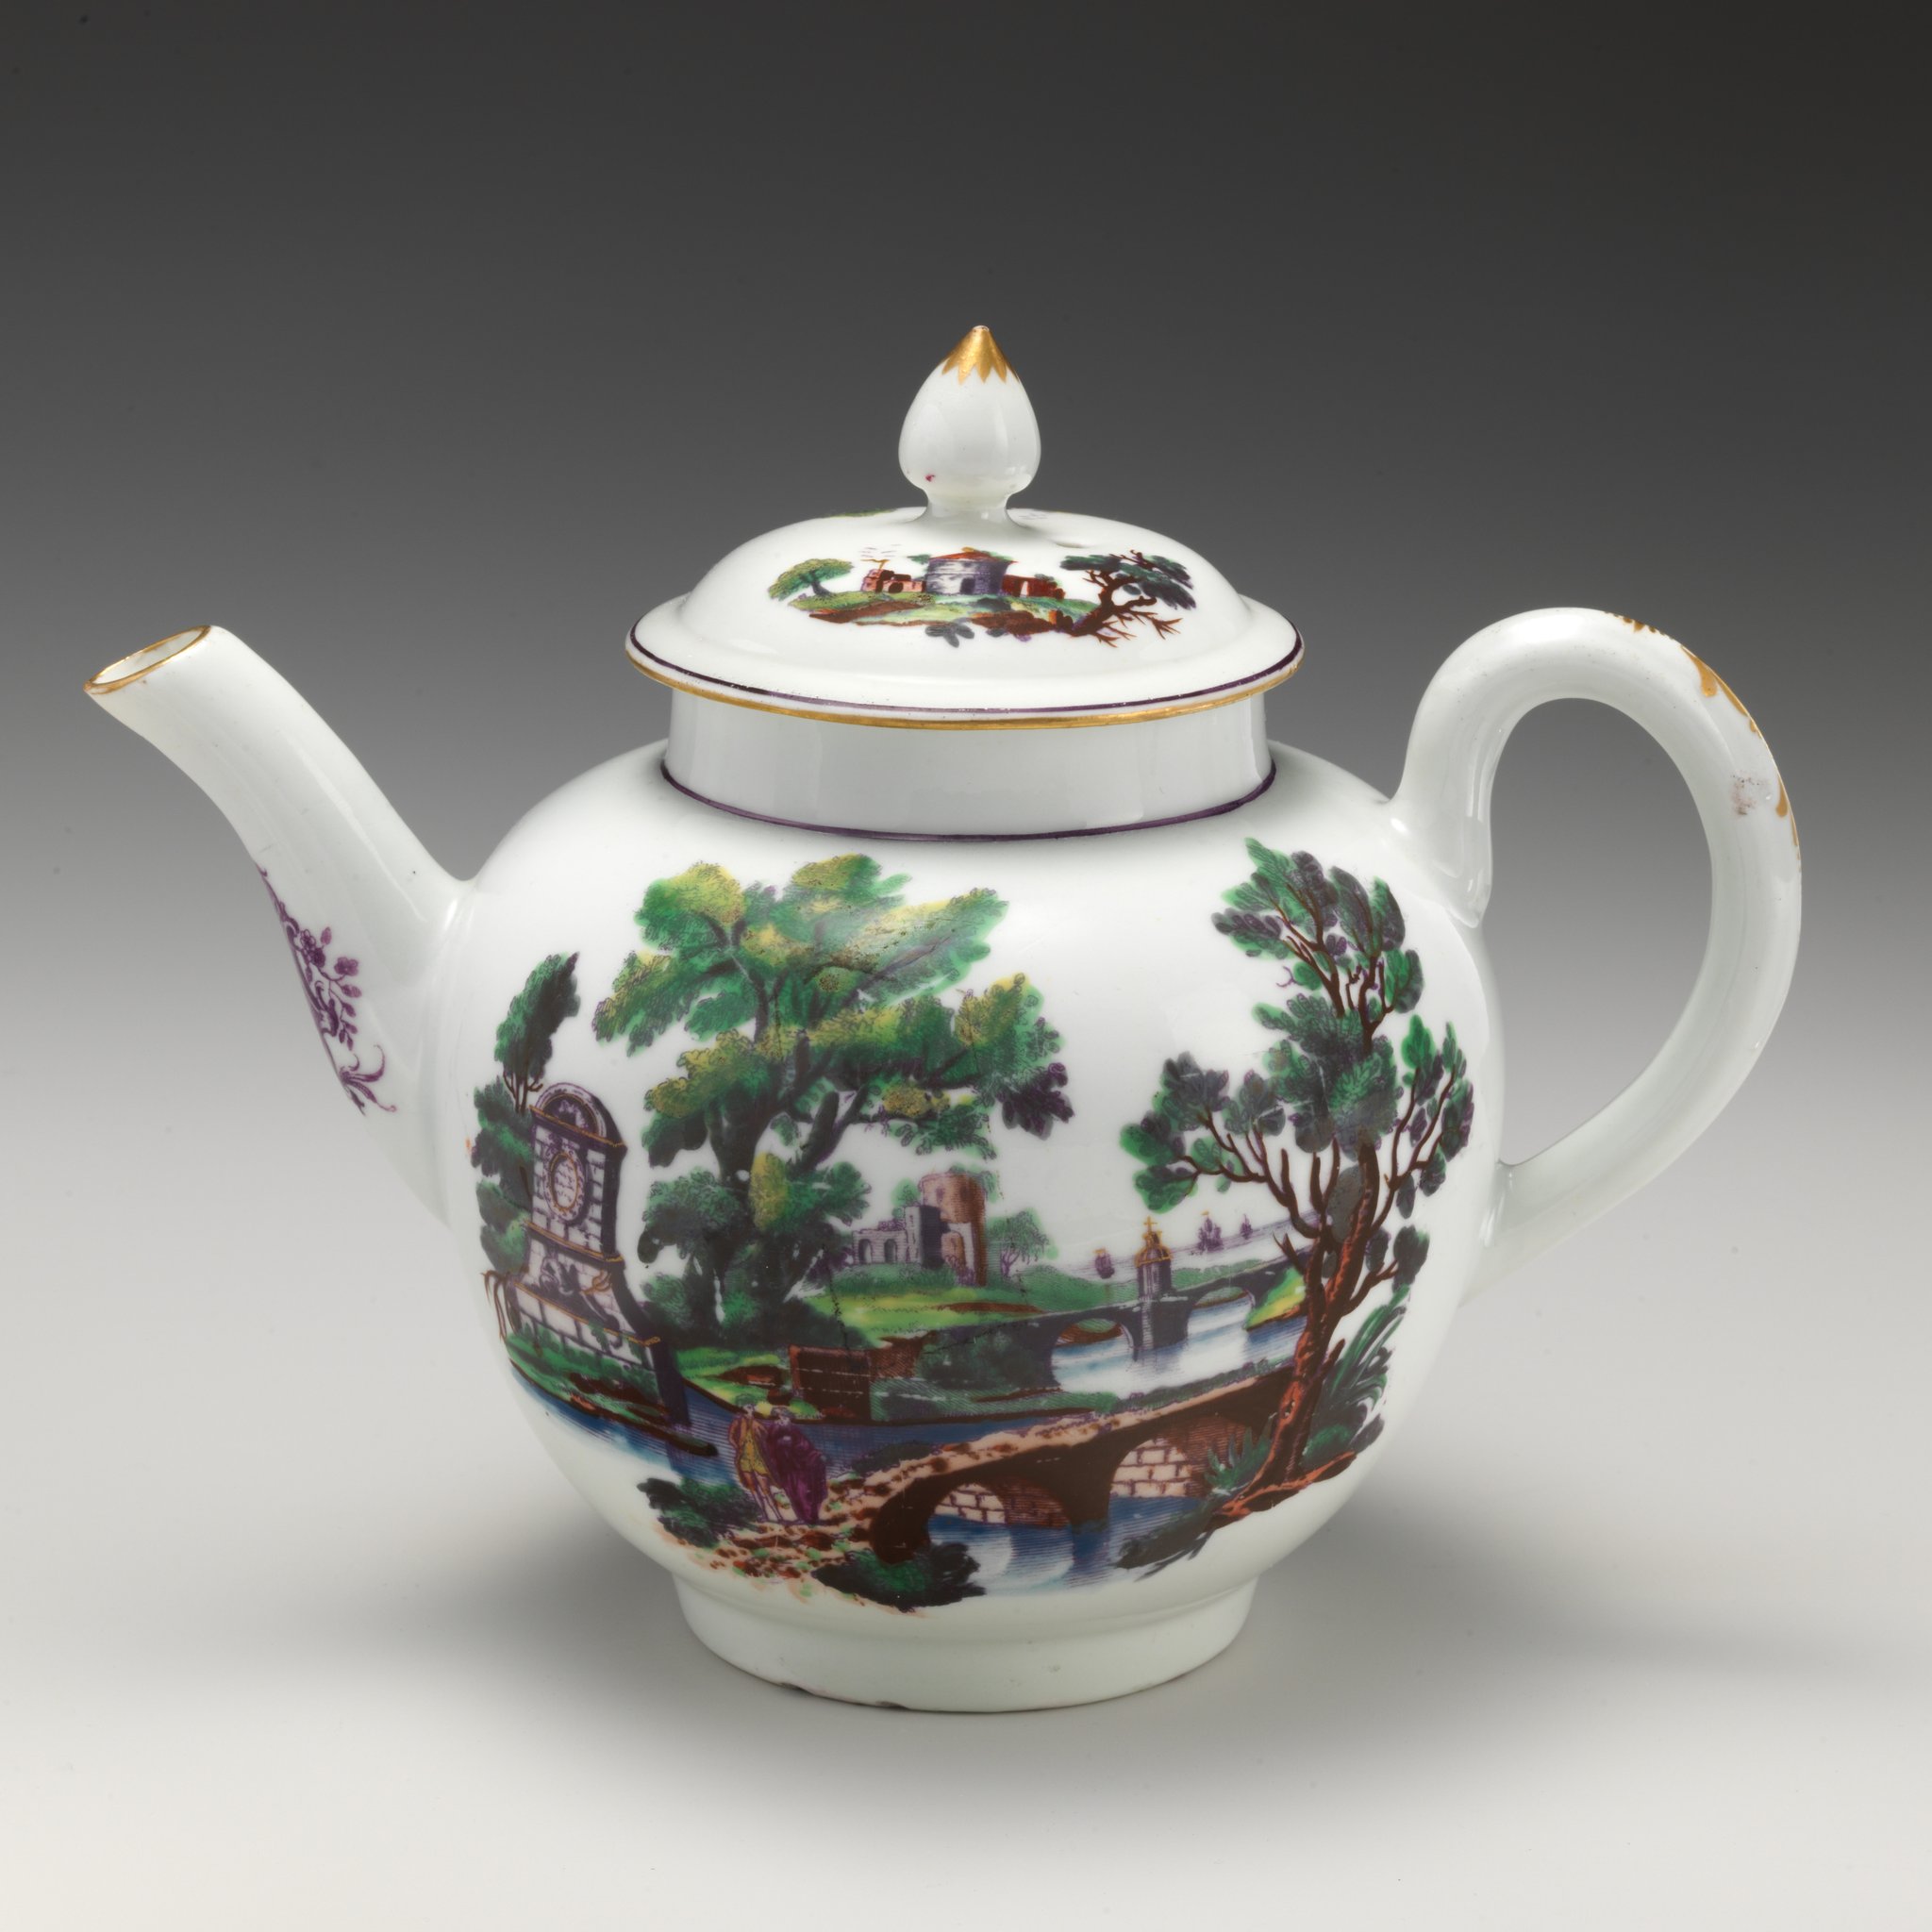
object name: teapot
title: Teapot with landscape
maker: worcester factory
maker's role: factory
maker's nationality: british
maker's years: 1751-2008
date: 1770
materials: soft paste porcelain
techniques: transfer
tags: bridges,men